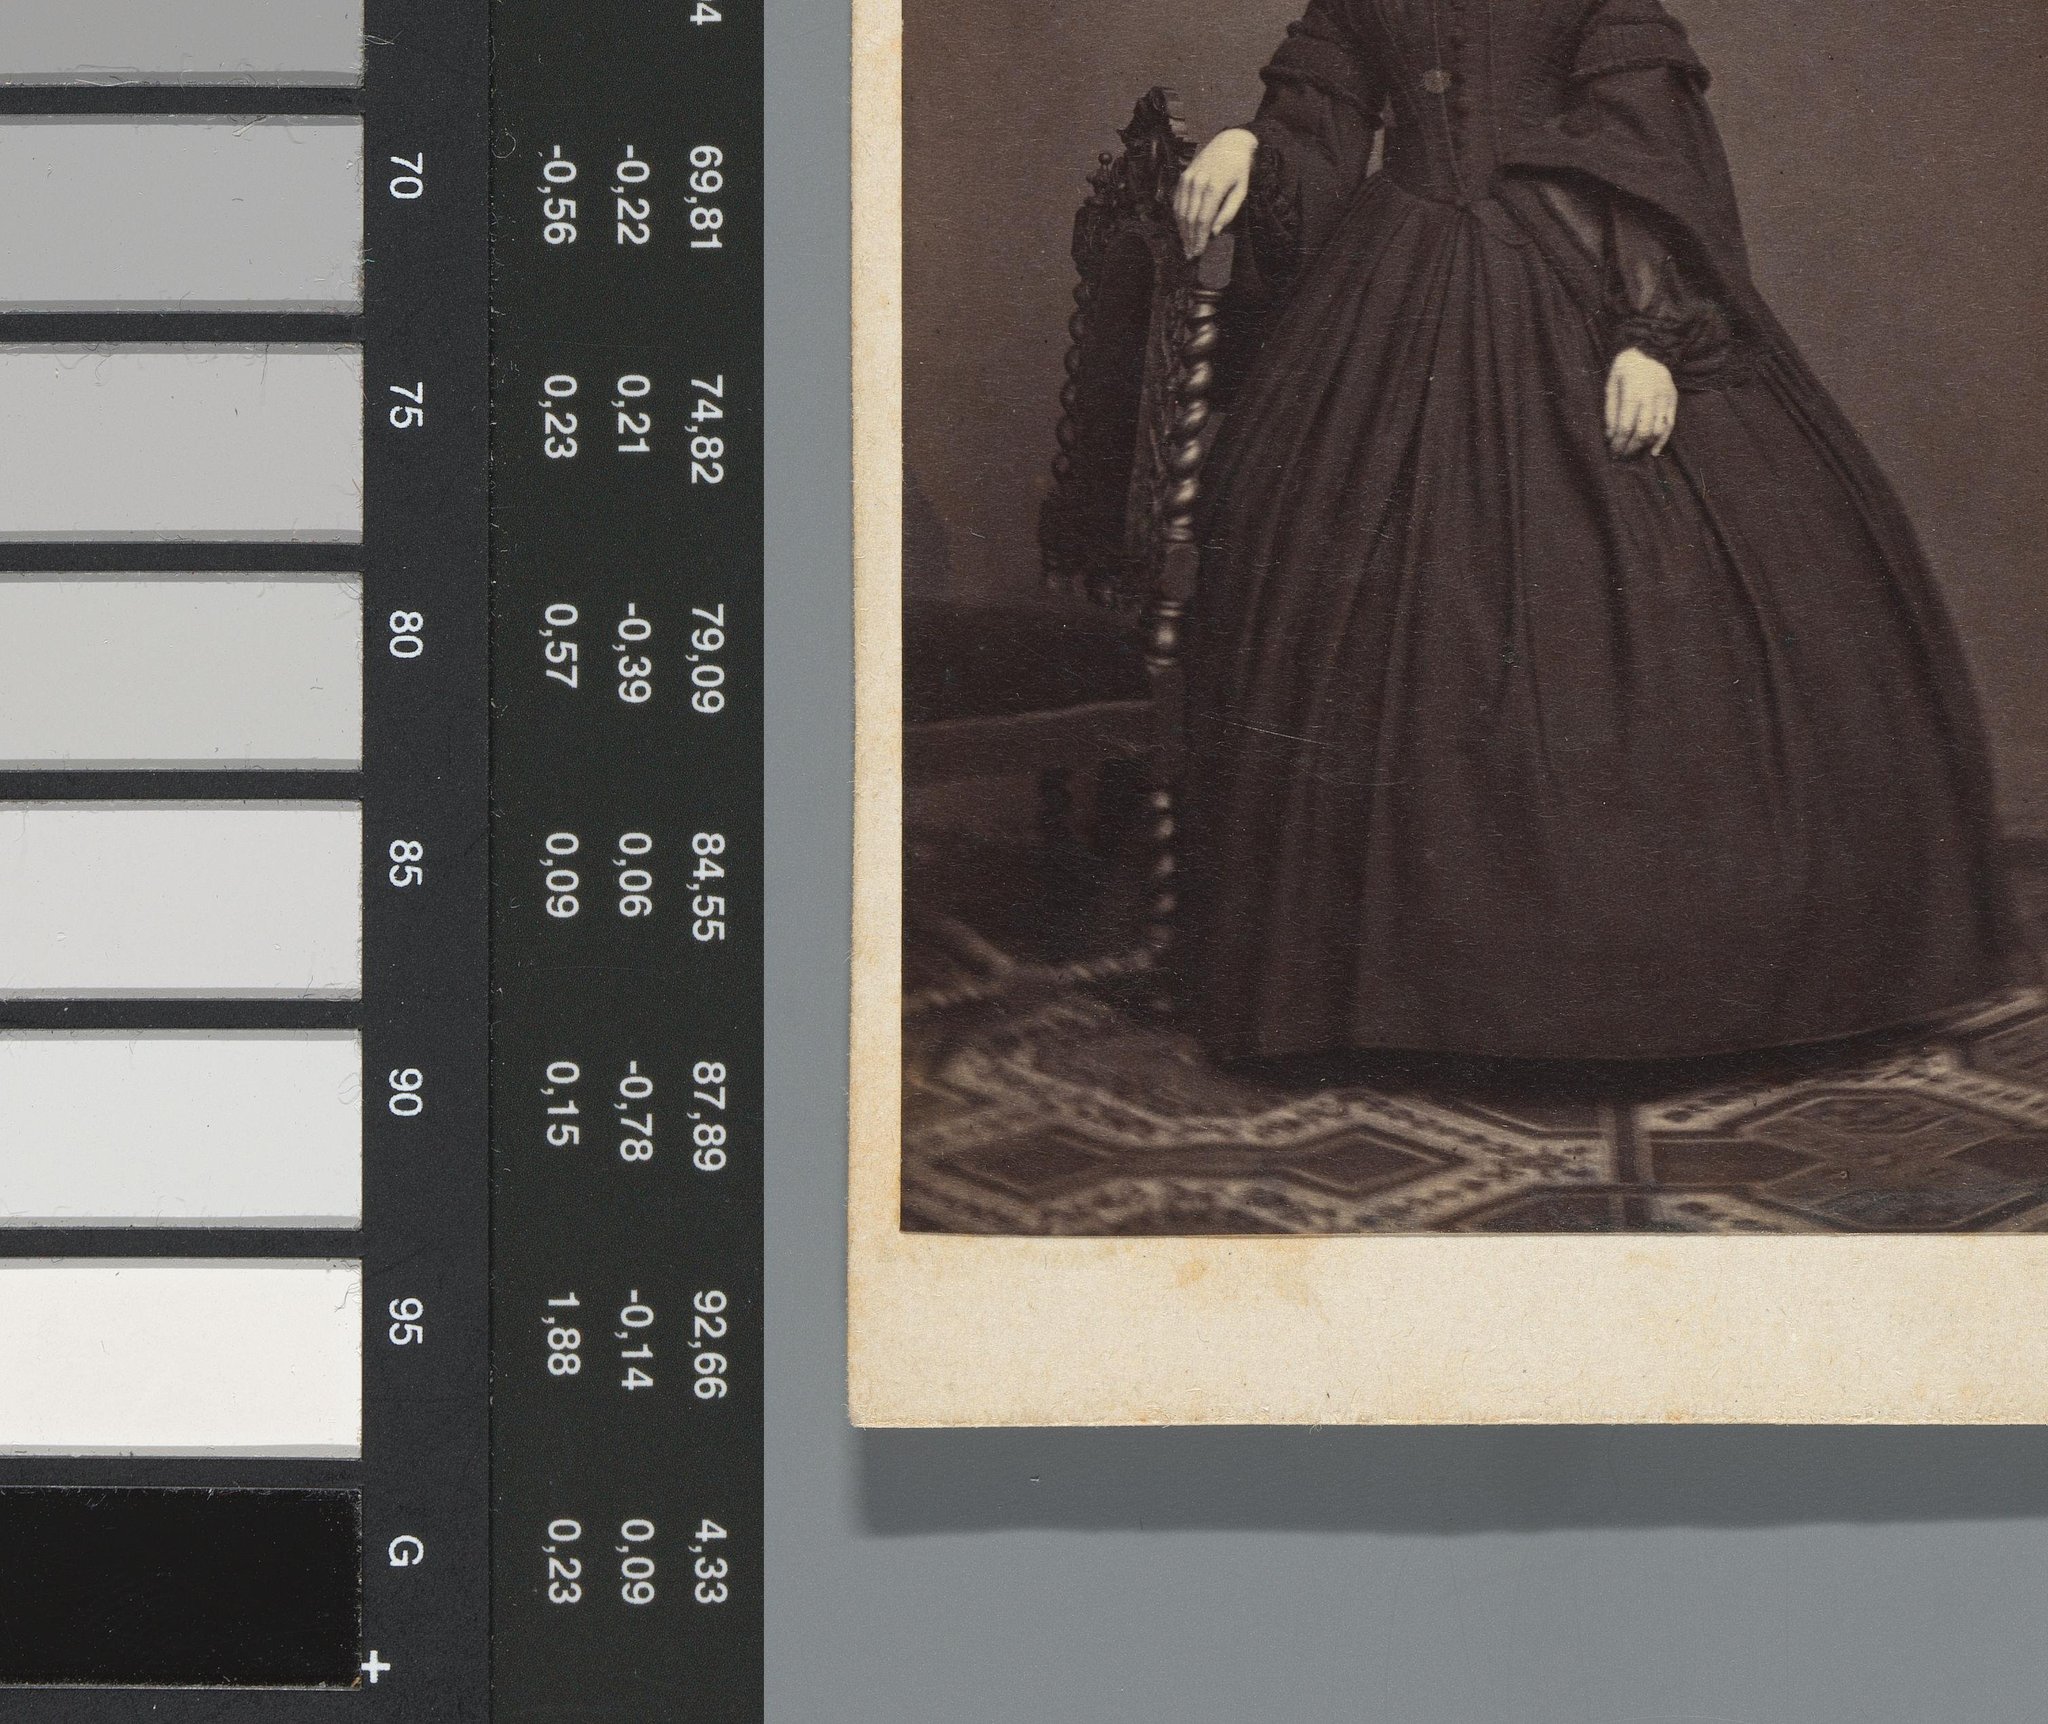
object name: carte de visite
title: Portret van mevrouw E.A.H. van Dooren-van Kerckhoff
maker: Anonymous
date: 1855-1910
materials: cardboard, photographic support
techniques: albumen print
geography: netherlands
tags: e.a.h. van dooren-van kerckhoff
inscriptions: inscription: ‘E.A.H. van Dooren- / van Kerckhoff’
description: Staande vrouw met een hand op de rugleuning van een stoel.